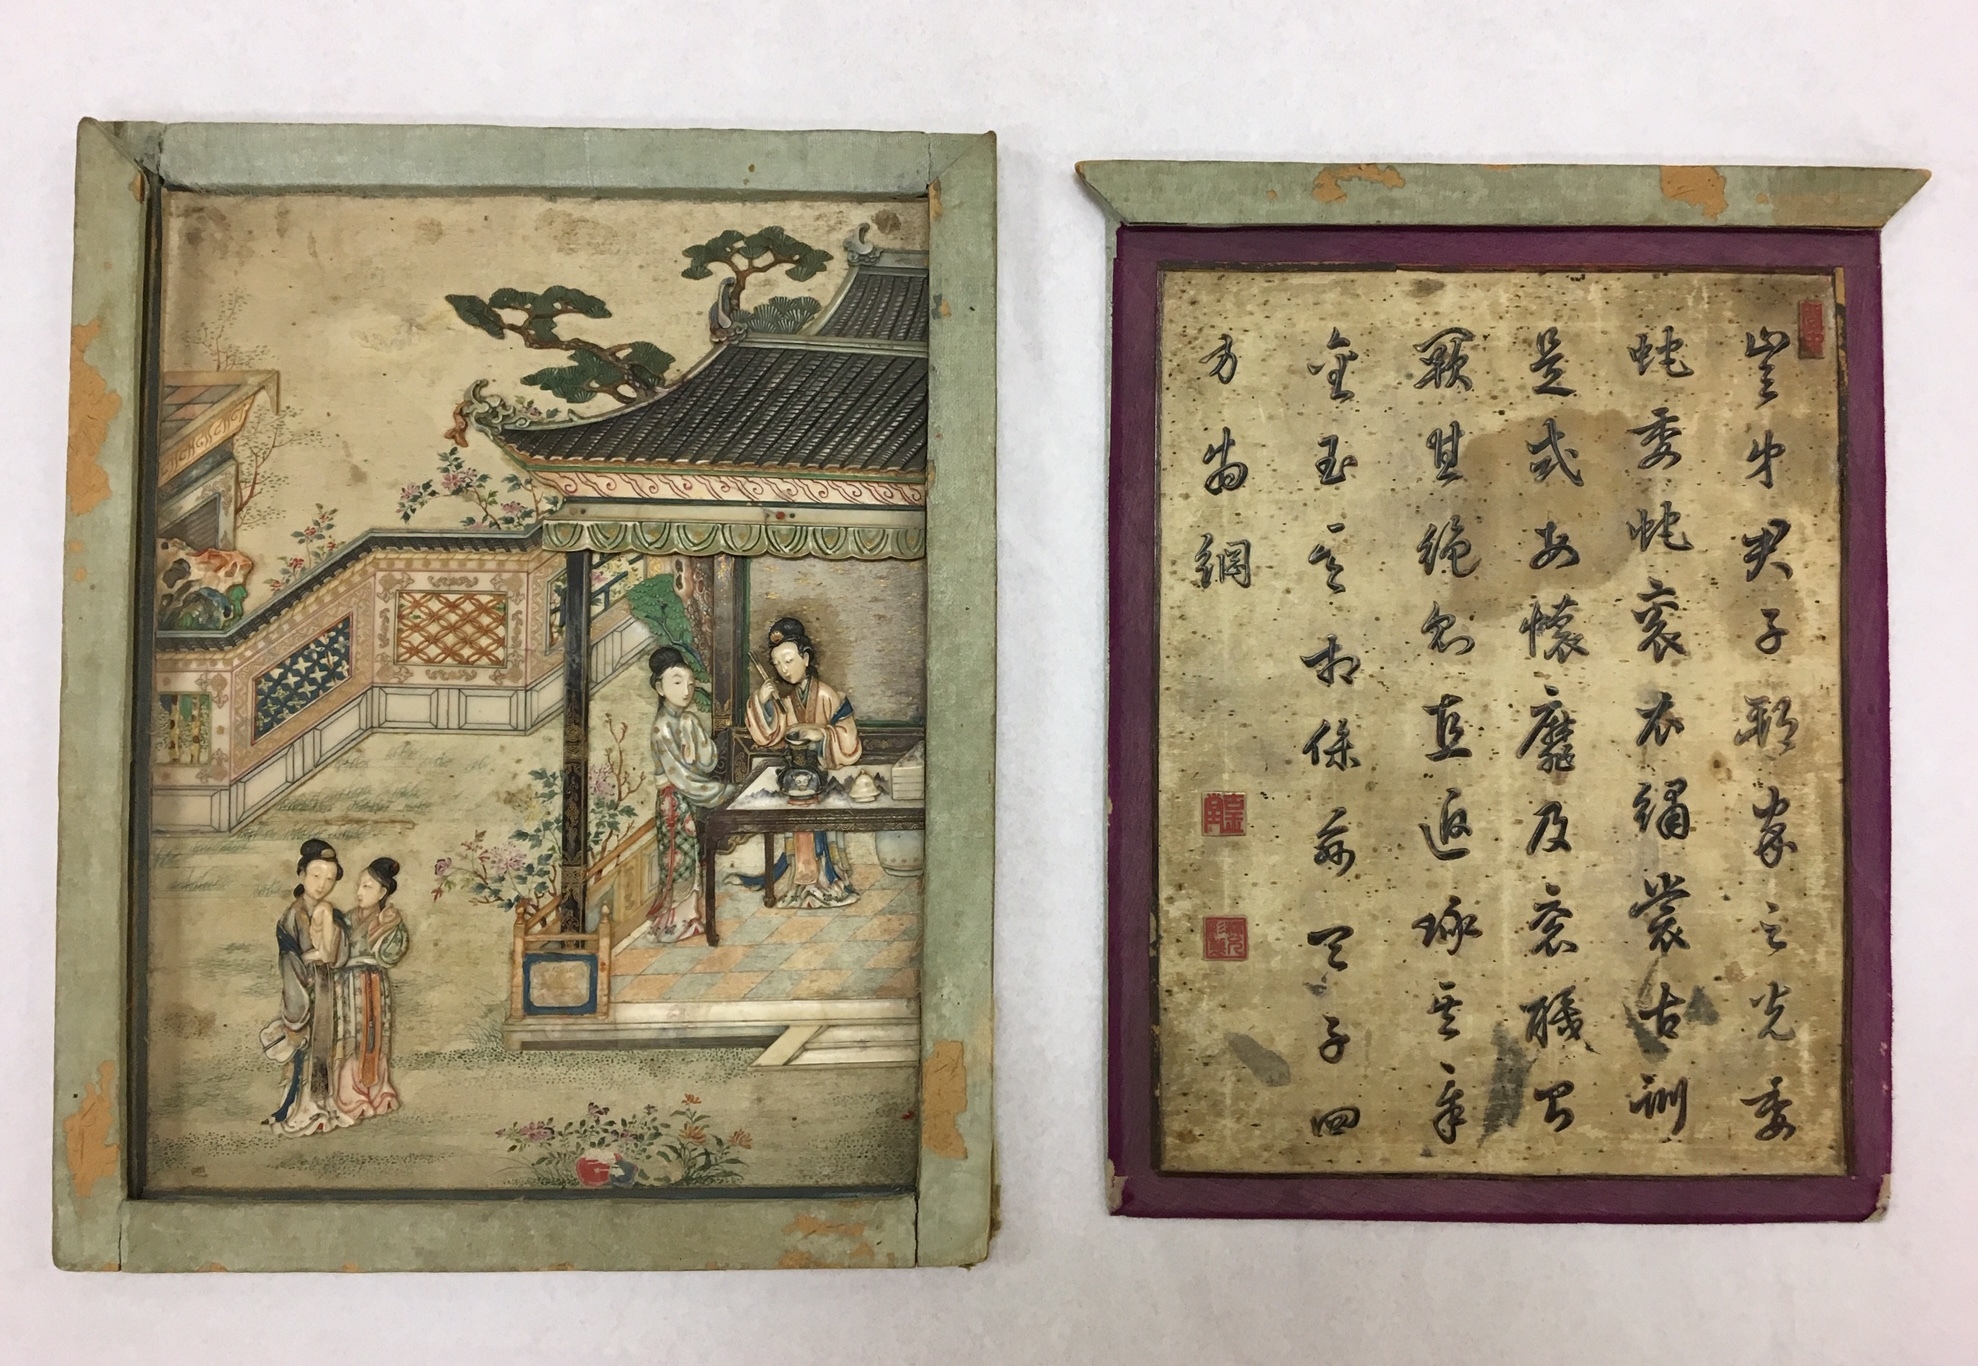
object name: panel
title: Panel Illustrating Feminine Virtue: The Art of Cooking or Hospitality (?)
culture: chinese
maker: lin yuncai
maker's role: artist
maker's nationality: chinese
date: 1601-1700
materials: paper, textile